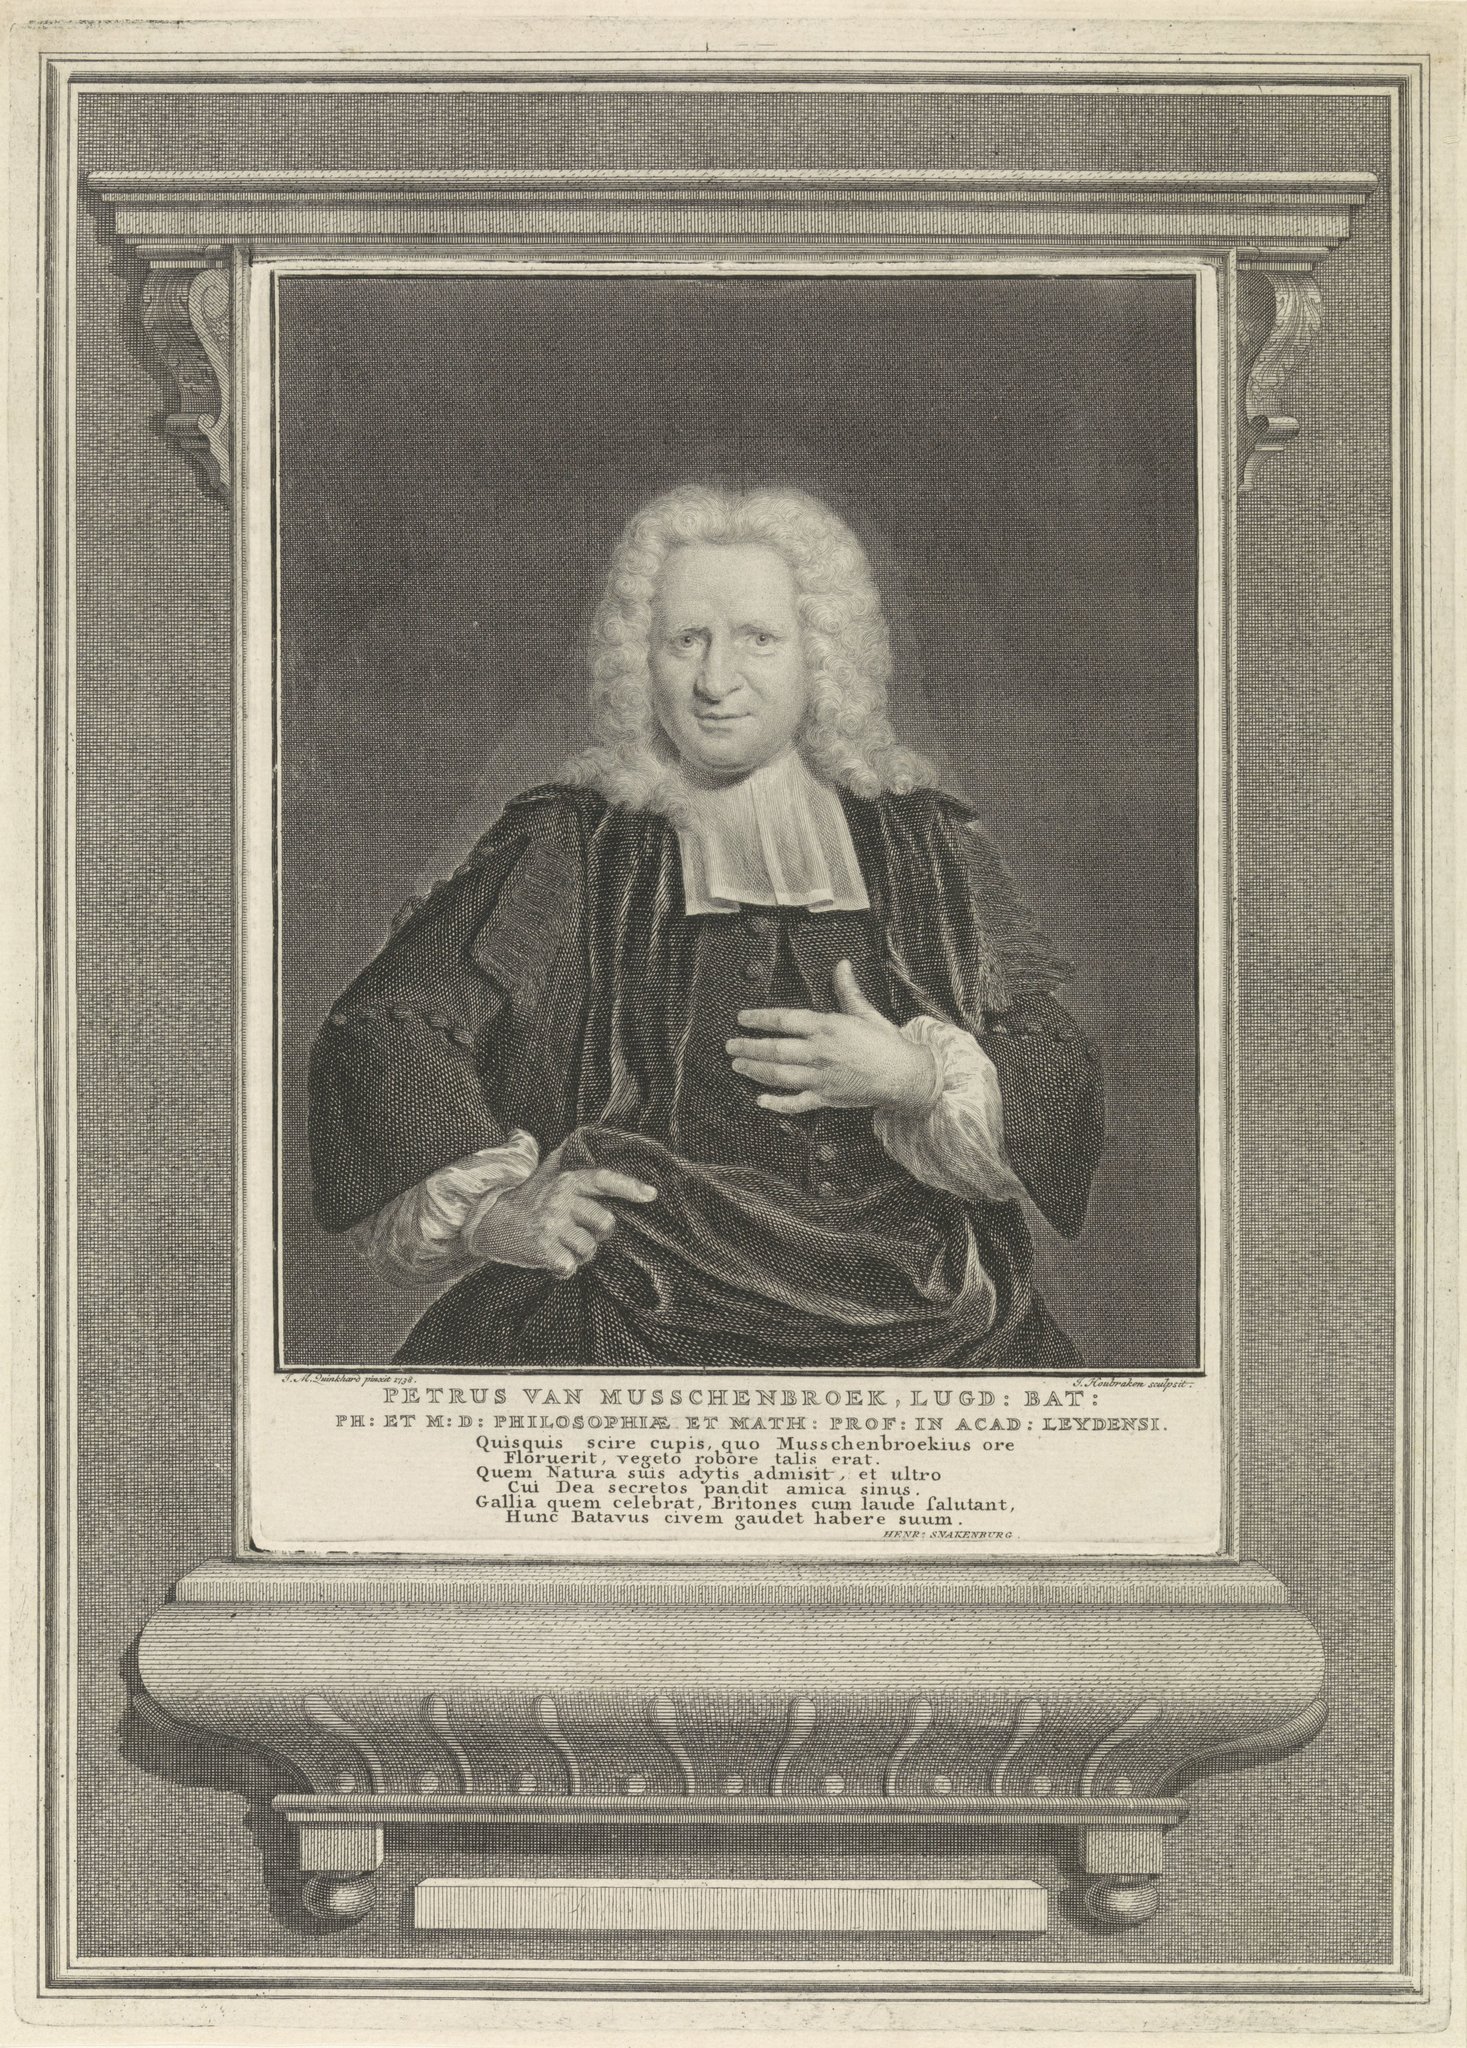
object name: print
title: Petrus van Musschenbroek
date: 1738-1780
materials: paper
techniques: engraving, etching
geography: amsterdam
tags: leiden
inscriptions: collector's mark: Lugt 2228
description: Portret ten halven lijve van Petrus van Musschenbroek. Onder het portret zijn naam en gegevens in twee regels in het Latijn en daaronder een zesregelige tekst in het Latijn. Rond het portret een afdruk van een tweede plaat met een omlijsting met een boven- en onderversiering om het portret.